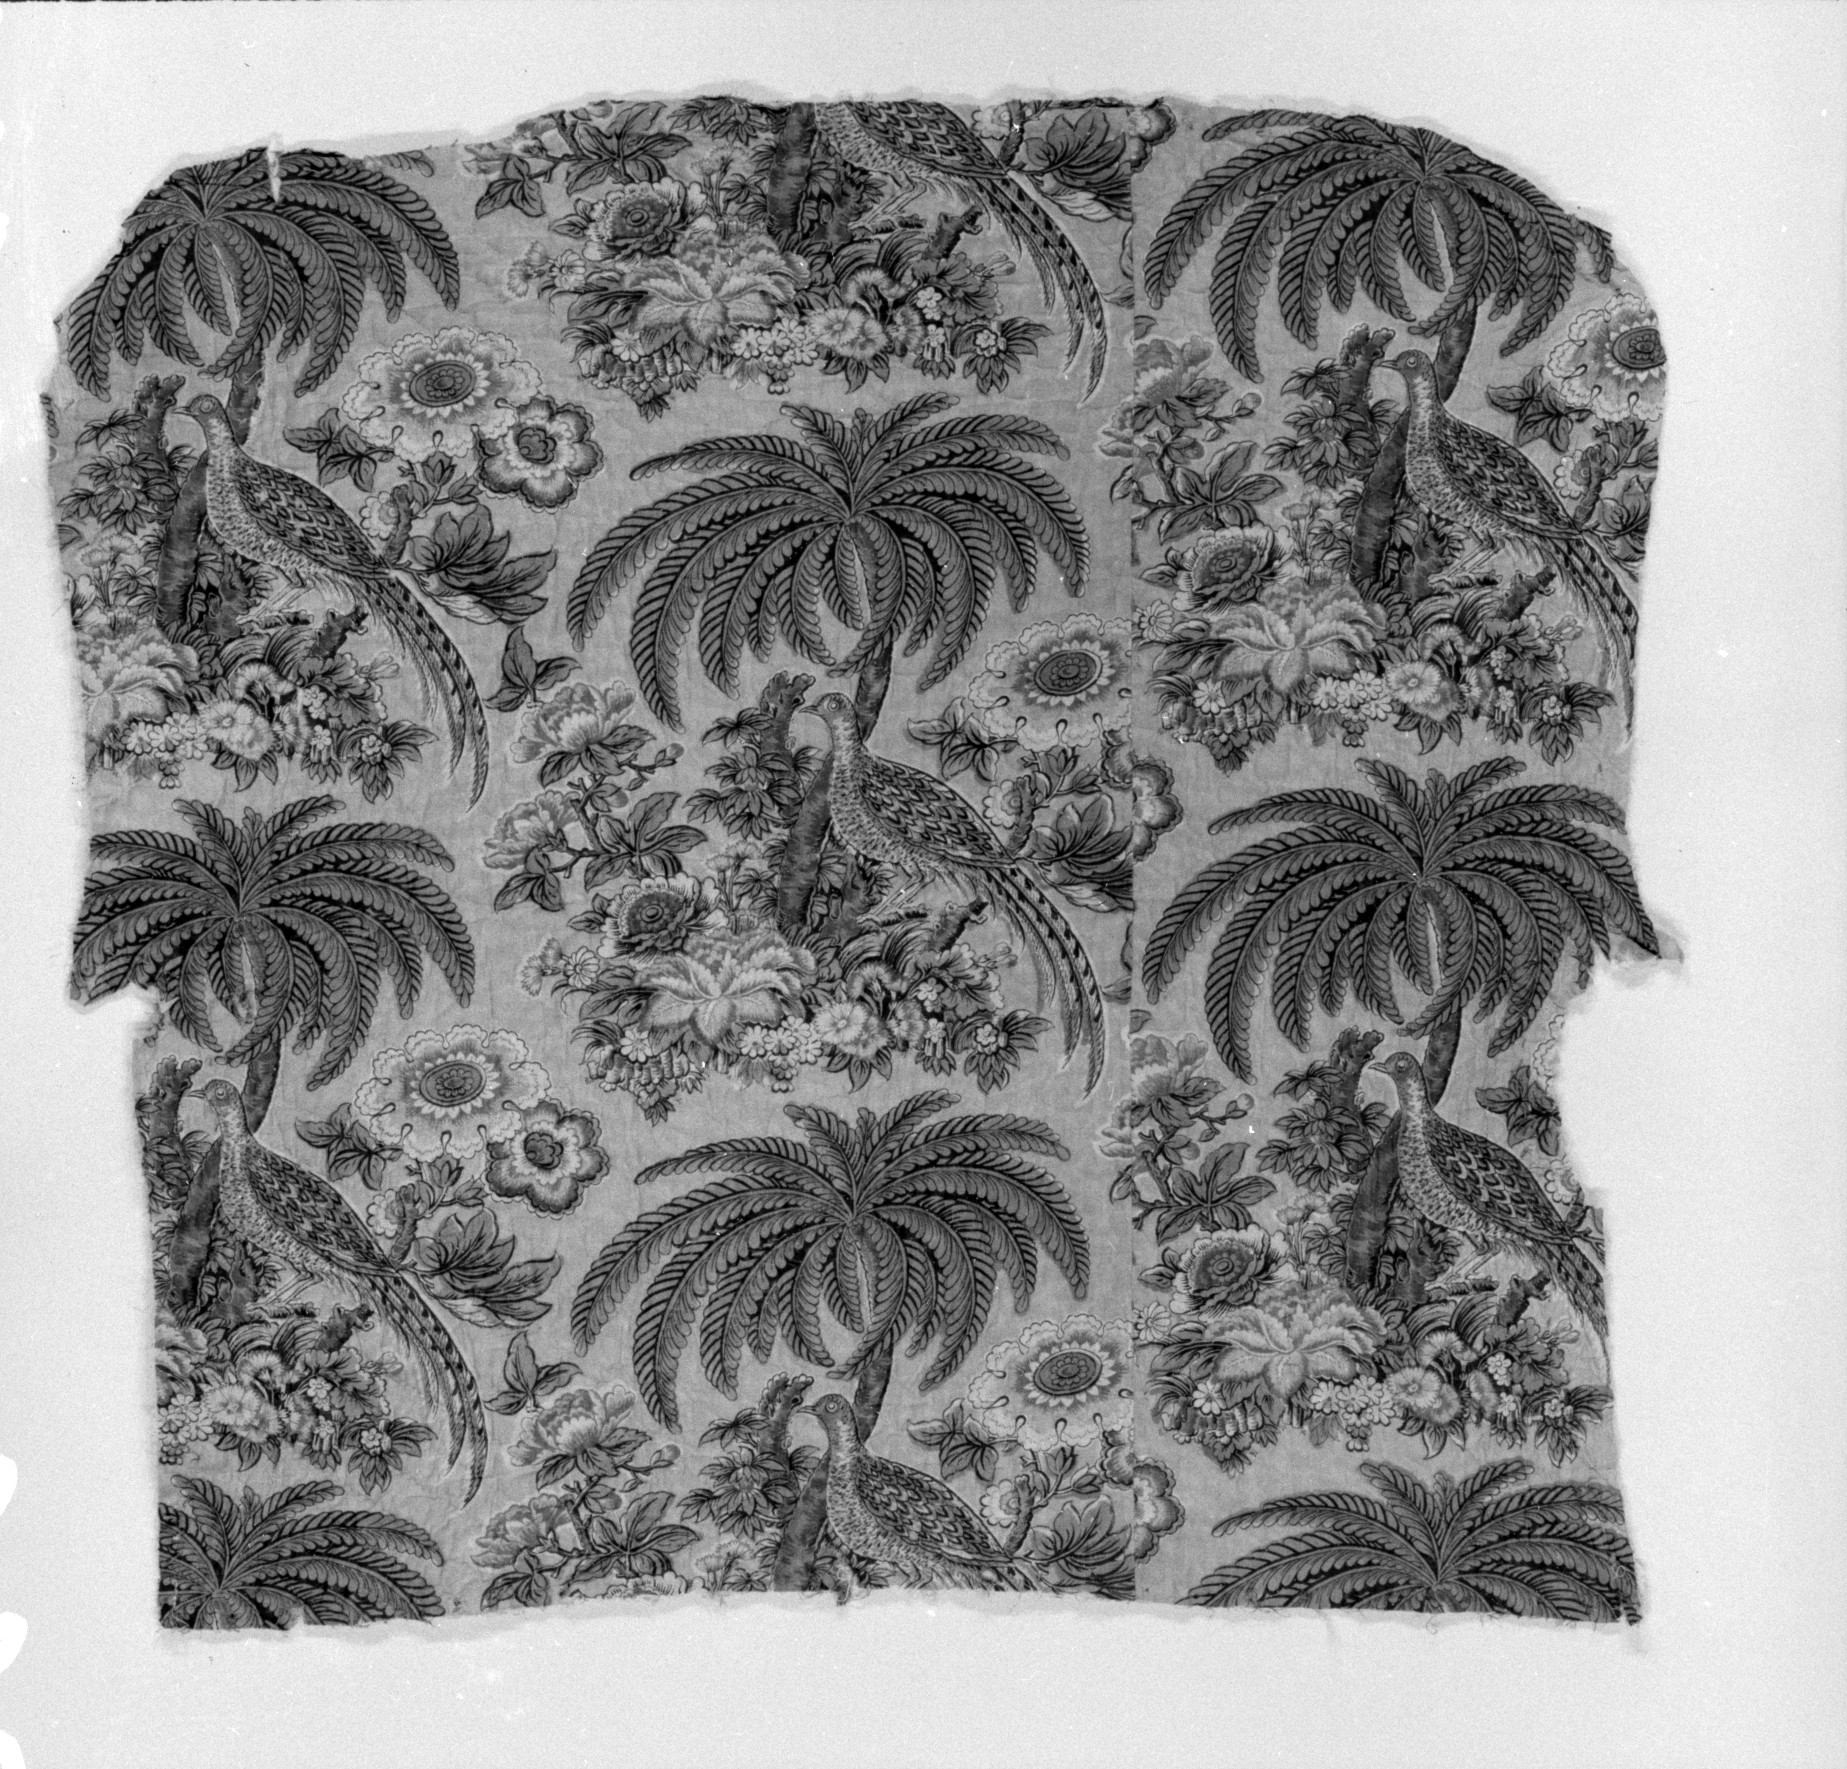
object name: printed piece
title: Piece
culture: british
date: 1830-1835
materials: cotton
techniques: printing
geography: england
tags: peacocks,flowers,trees